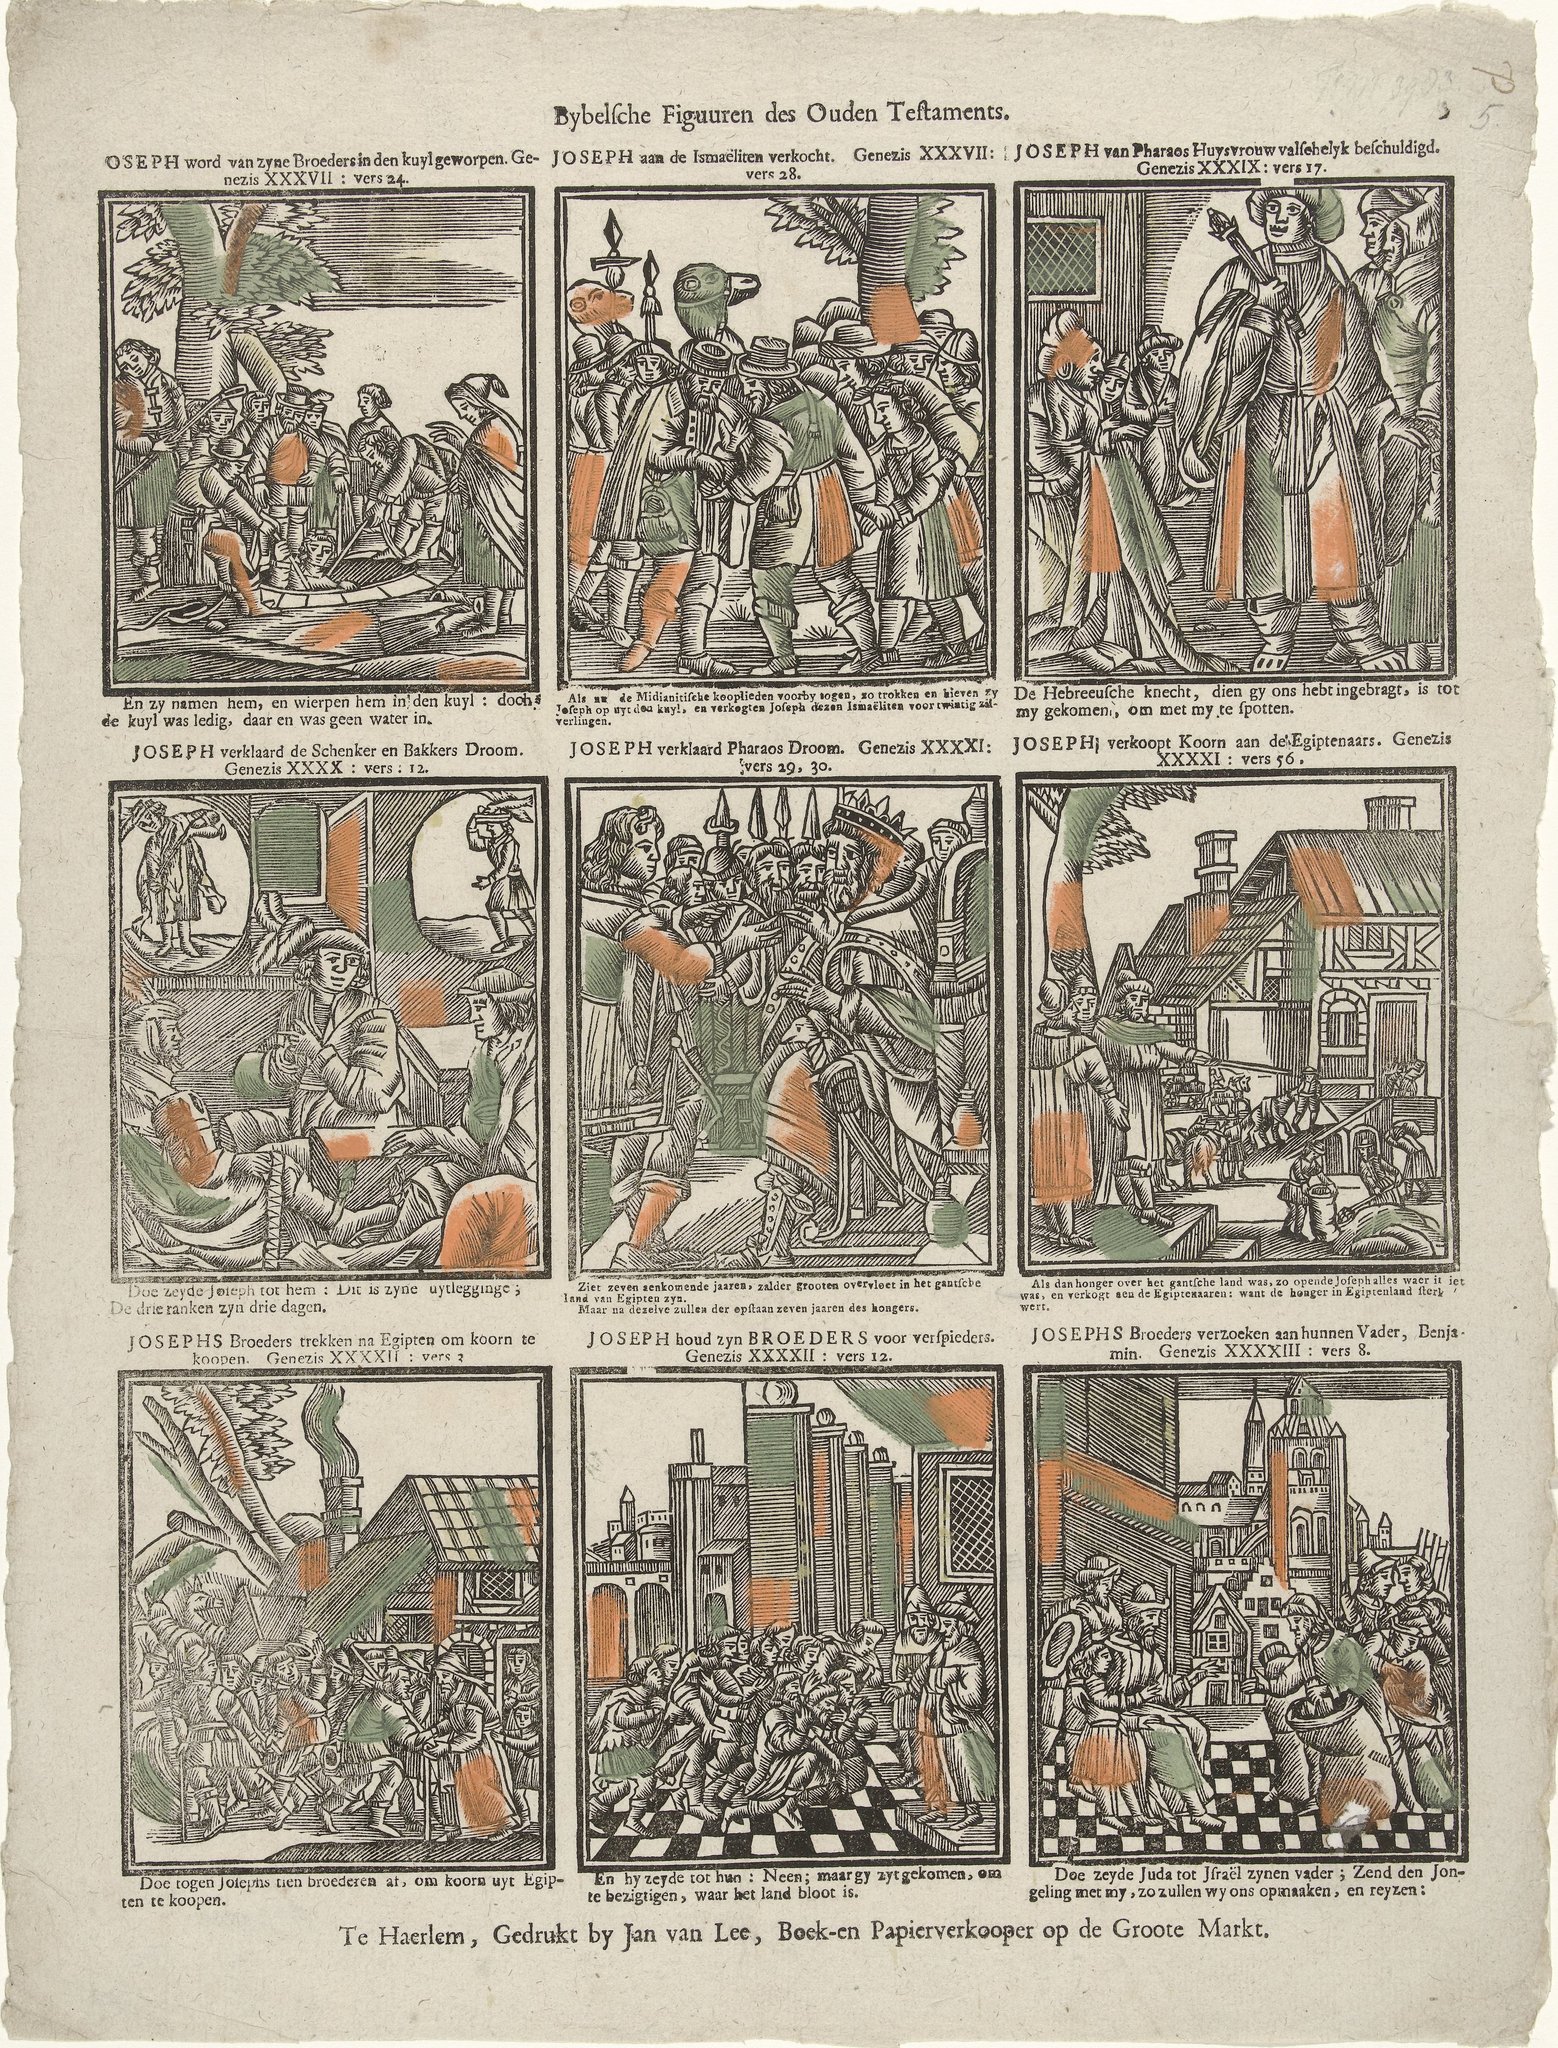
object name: print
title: Bybelsche Figuuren, des Ouden Testaments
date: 1739-1786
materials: paper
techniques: colour, letterpress printing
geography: haarlem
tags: genesis: the story of joseph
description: Blad met 9 voorstellingen van het verhaal van Jozef in het Oude Testament. Boven elk plaatje een titel en de bijbelverwijzing, eronder het bewuste vers. Genummerd: 3 (of 5).